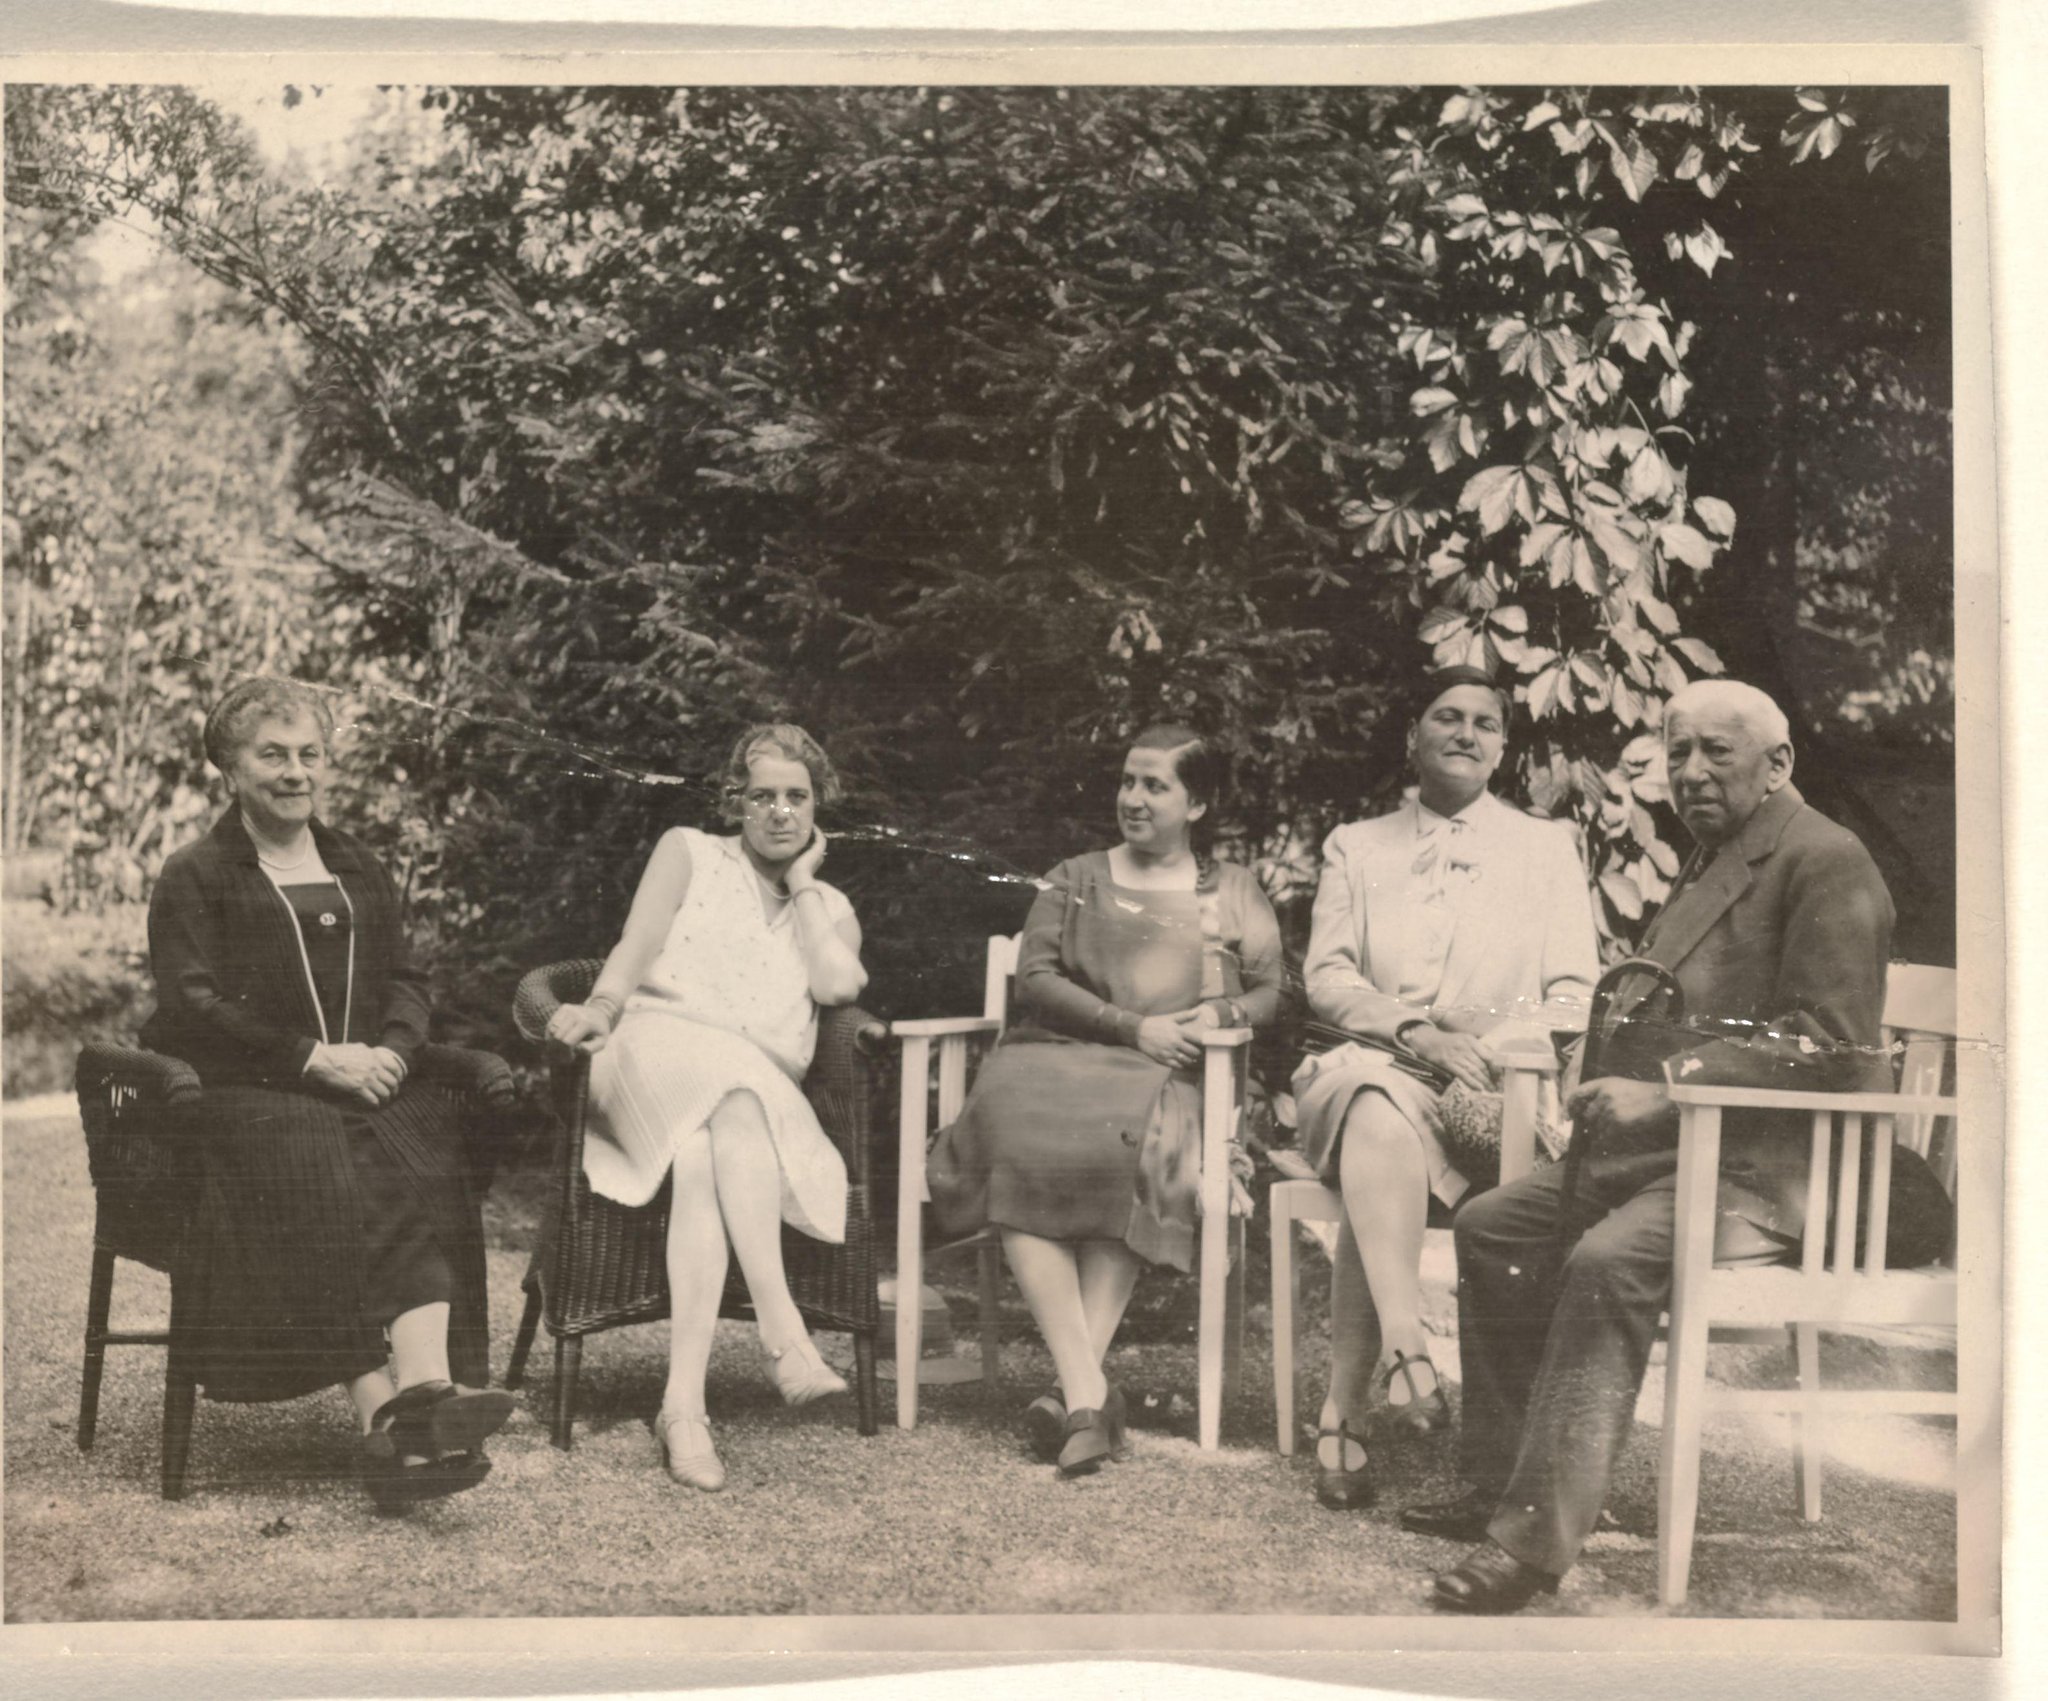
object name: photograph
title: Josefine Moos-Levi, een ongeïndentificeerde vrouw, Else Wachenheimer-Moos, een onbekende vrouw en Hermann Moos gezeten in een tuin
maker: Anonymous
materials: photographic support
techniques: gelatin silver print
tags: else wachenheimer-moos, josefine moos-levi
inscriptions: number: ‘953’